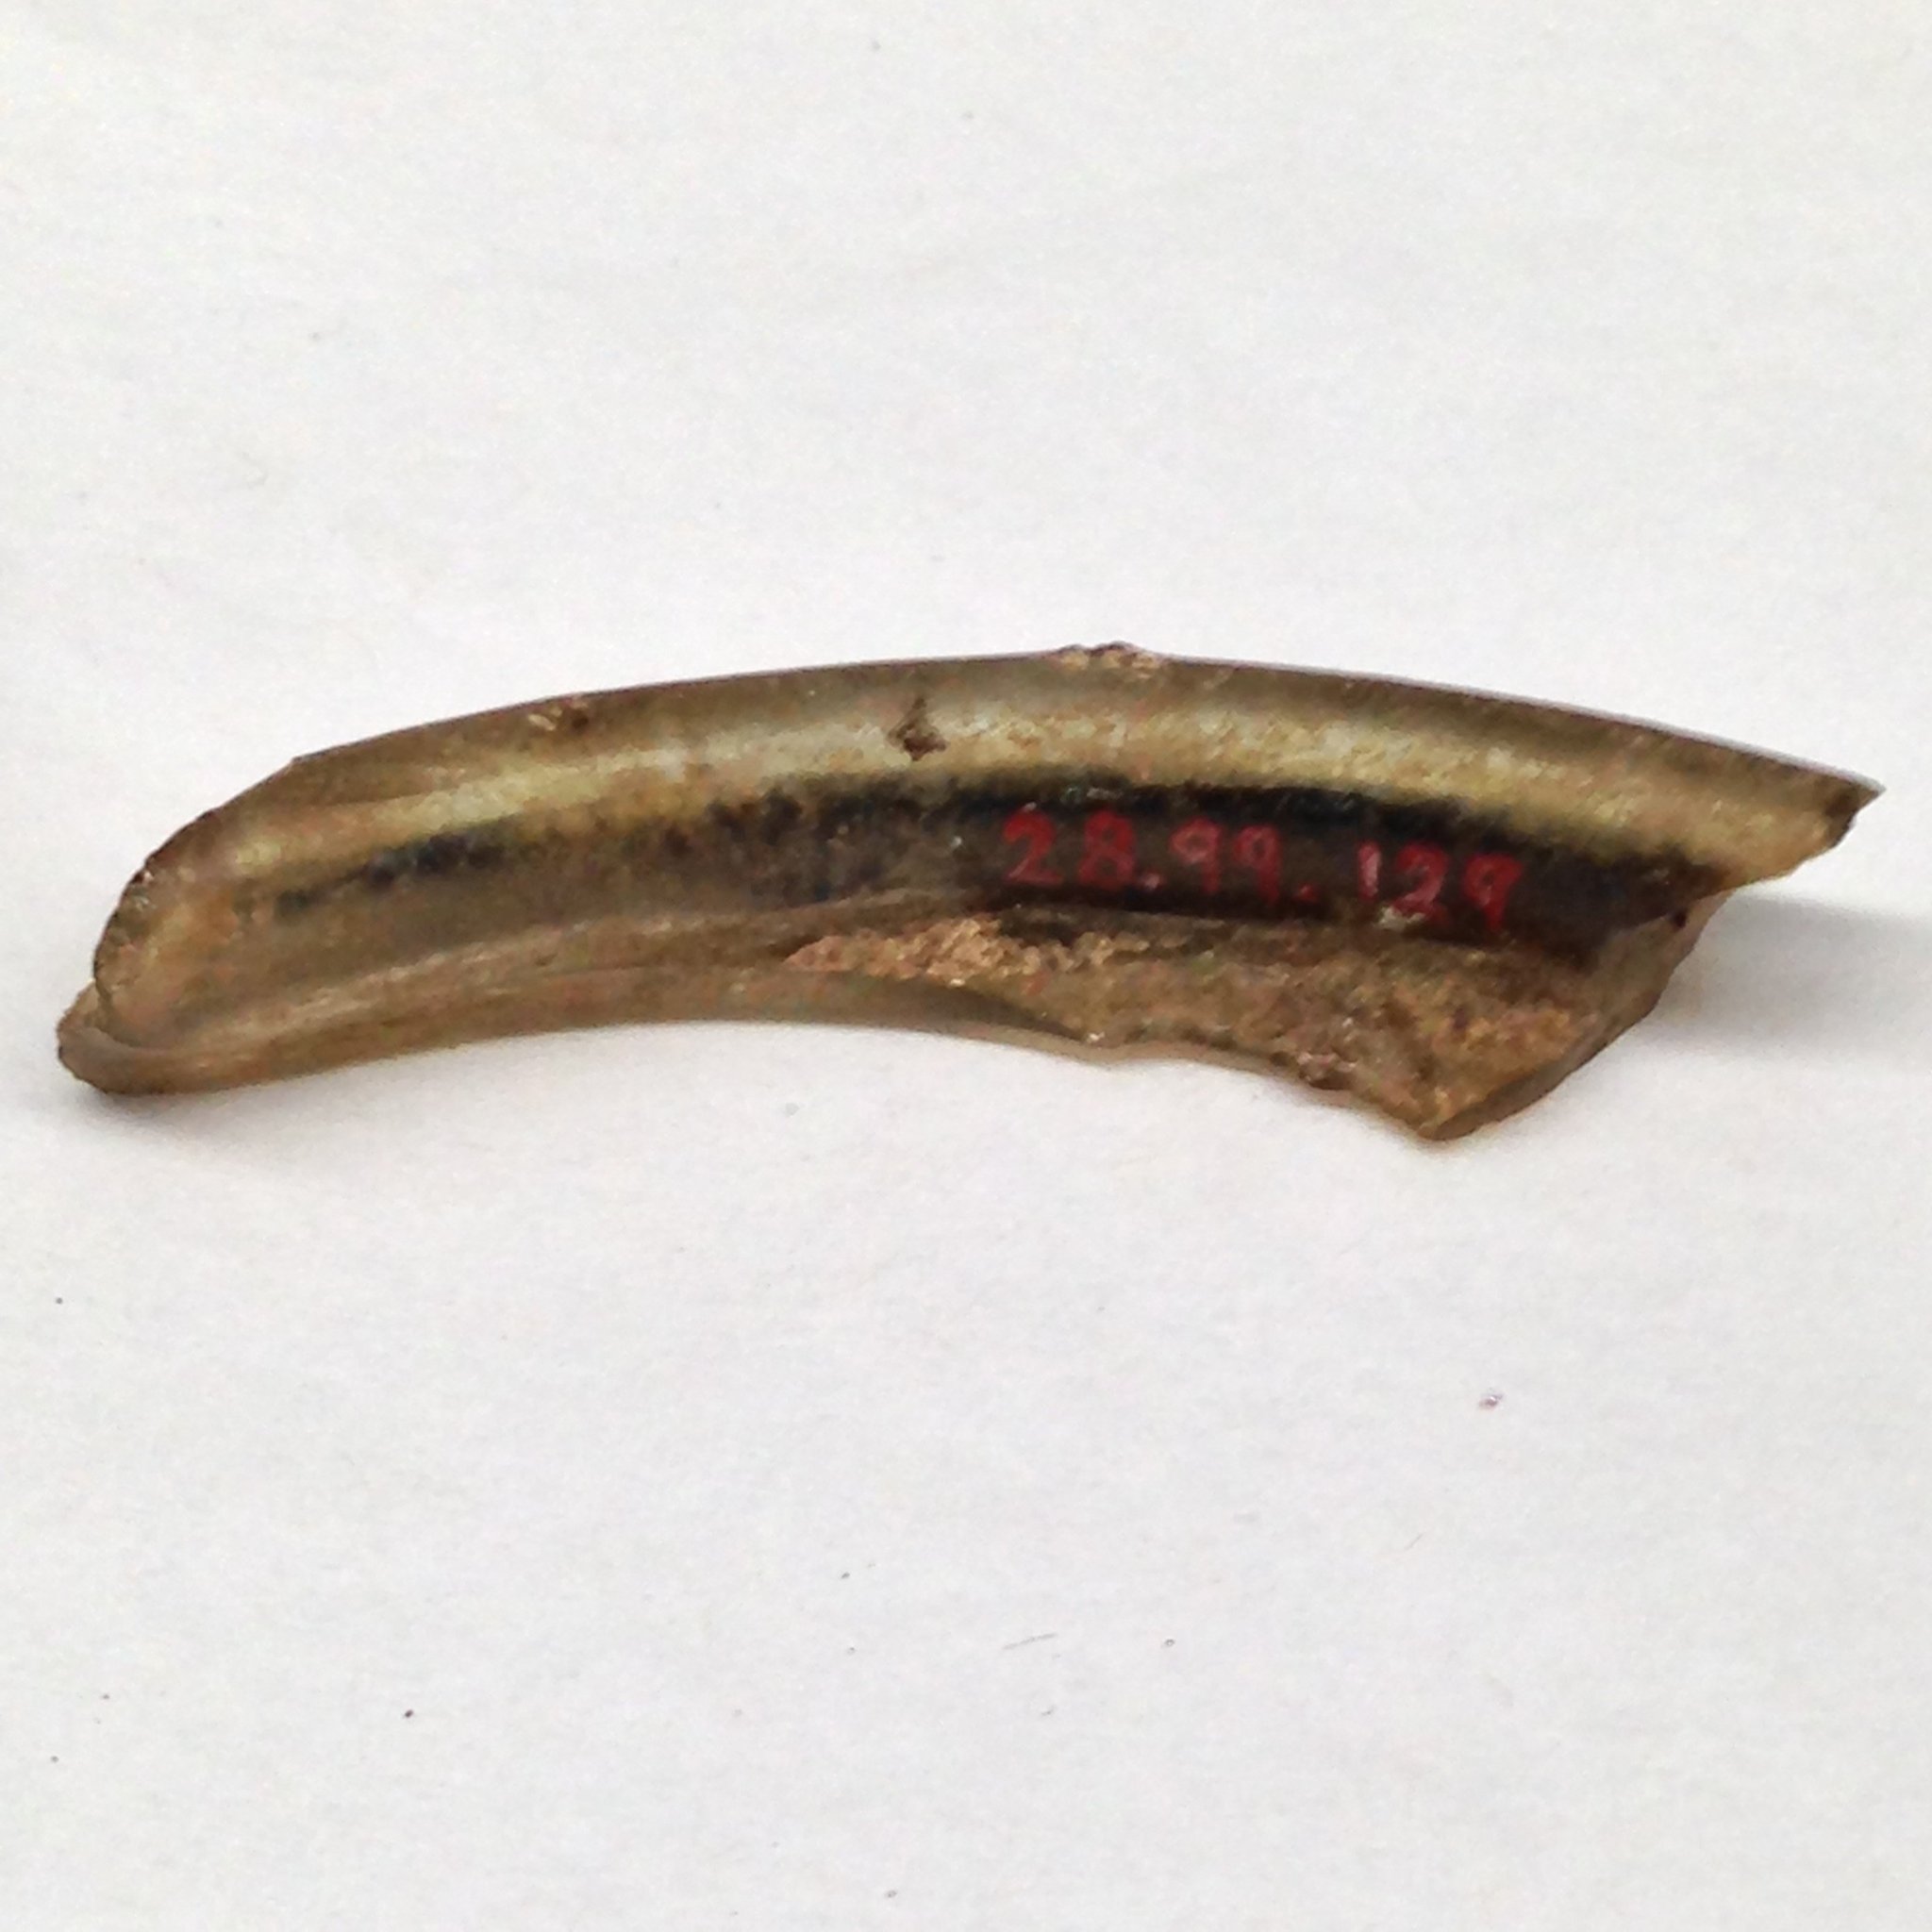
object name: fragment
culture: european or middle eastern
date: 1150-1250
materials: ceramic, glass